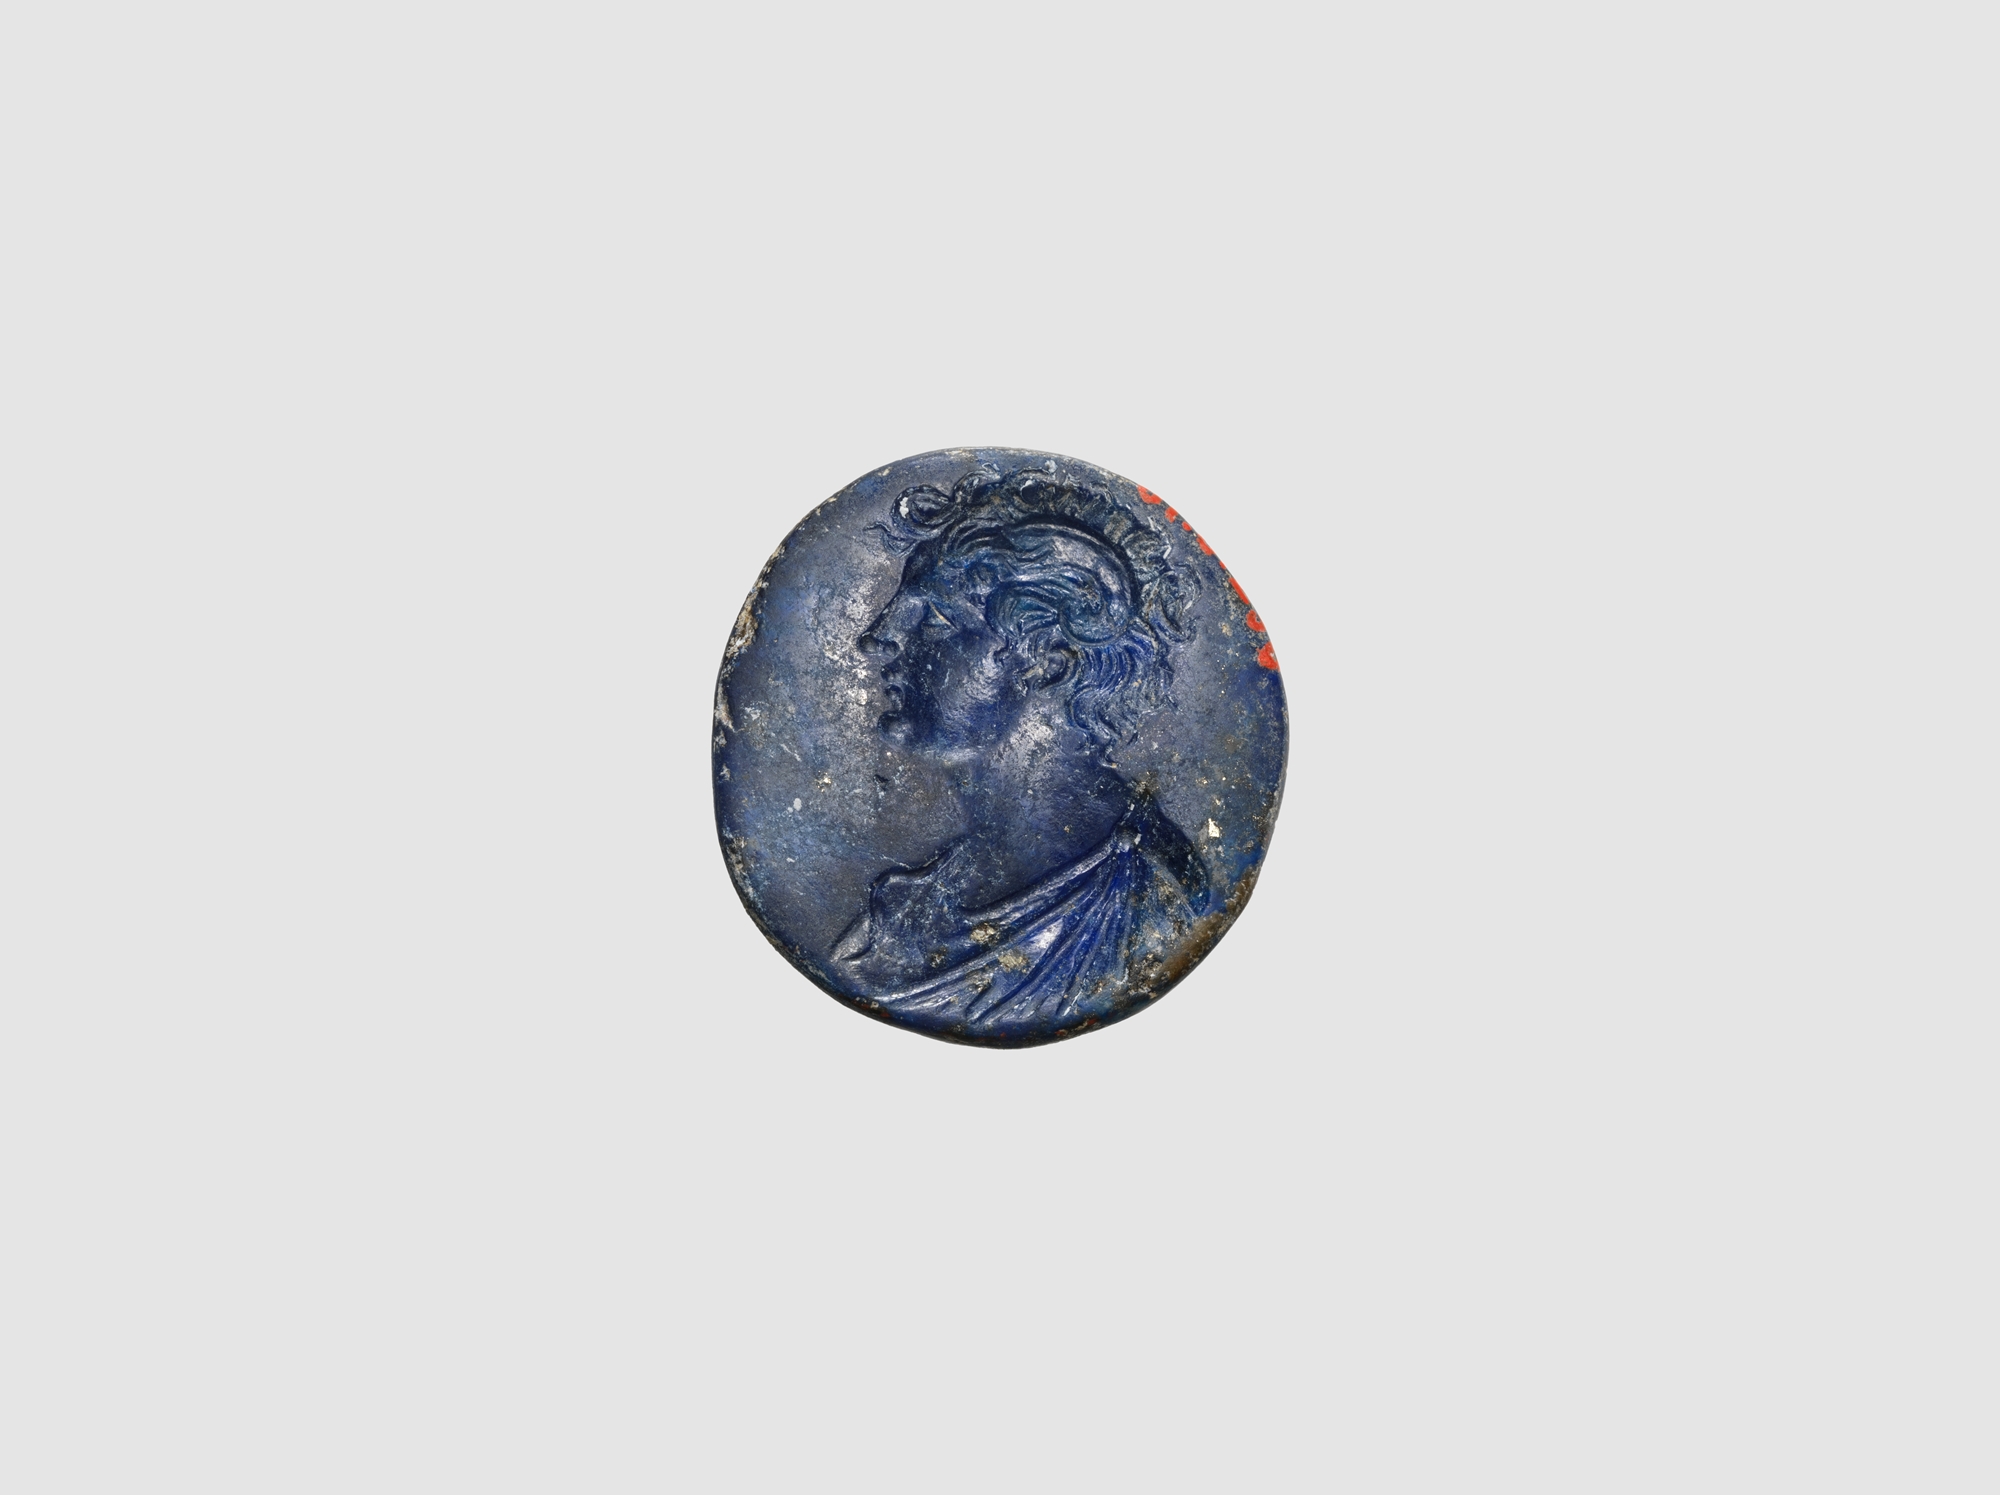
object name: intaglio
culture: post-classical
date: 7000 BCE-330 CE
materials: lapis lazuli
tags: alexander the great,profiles,aphrodite,apollo